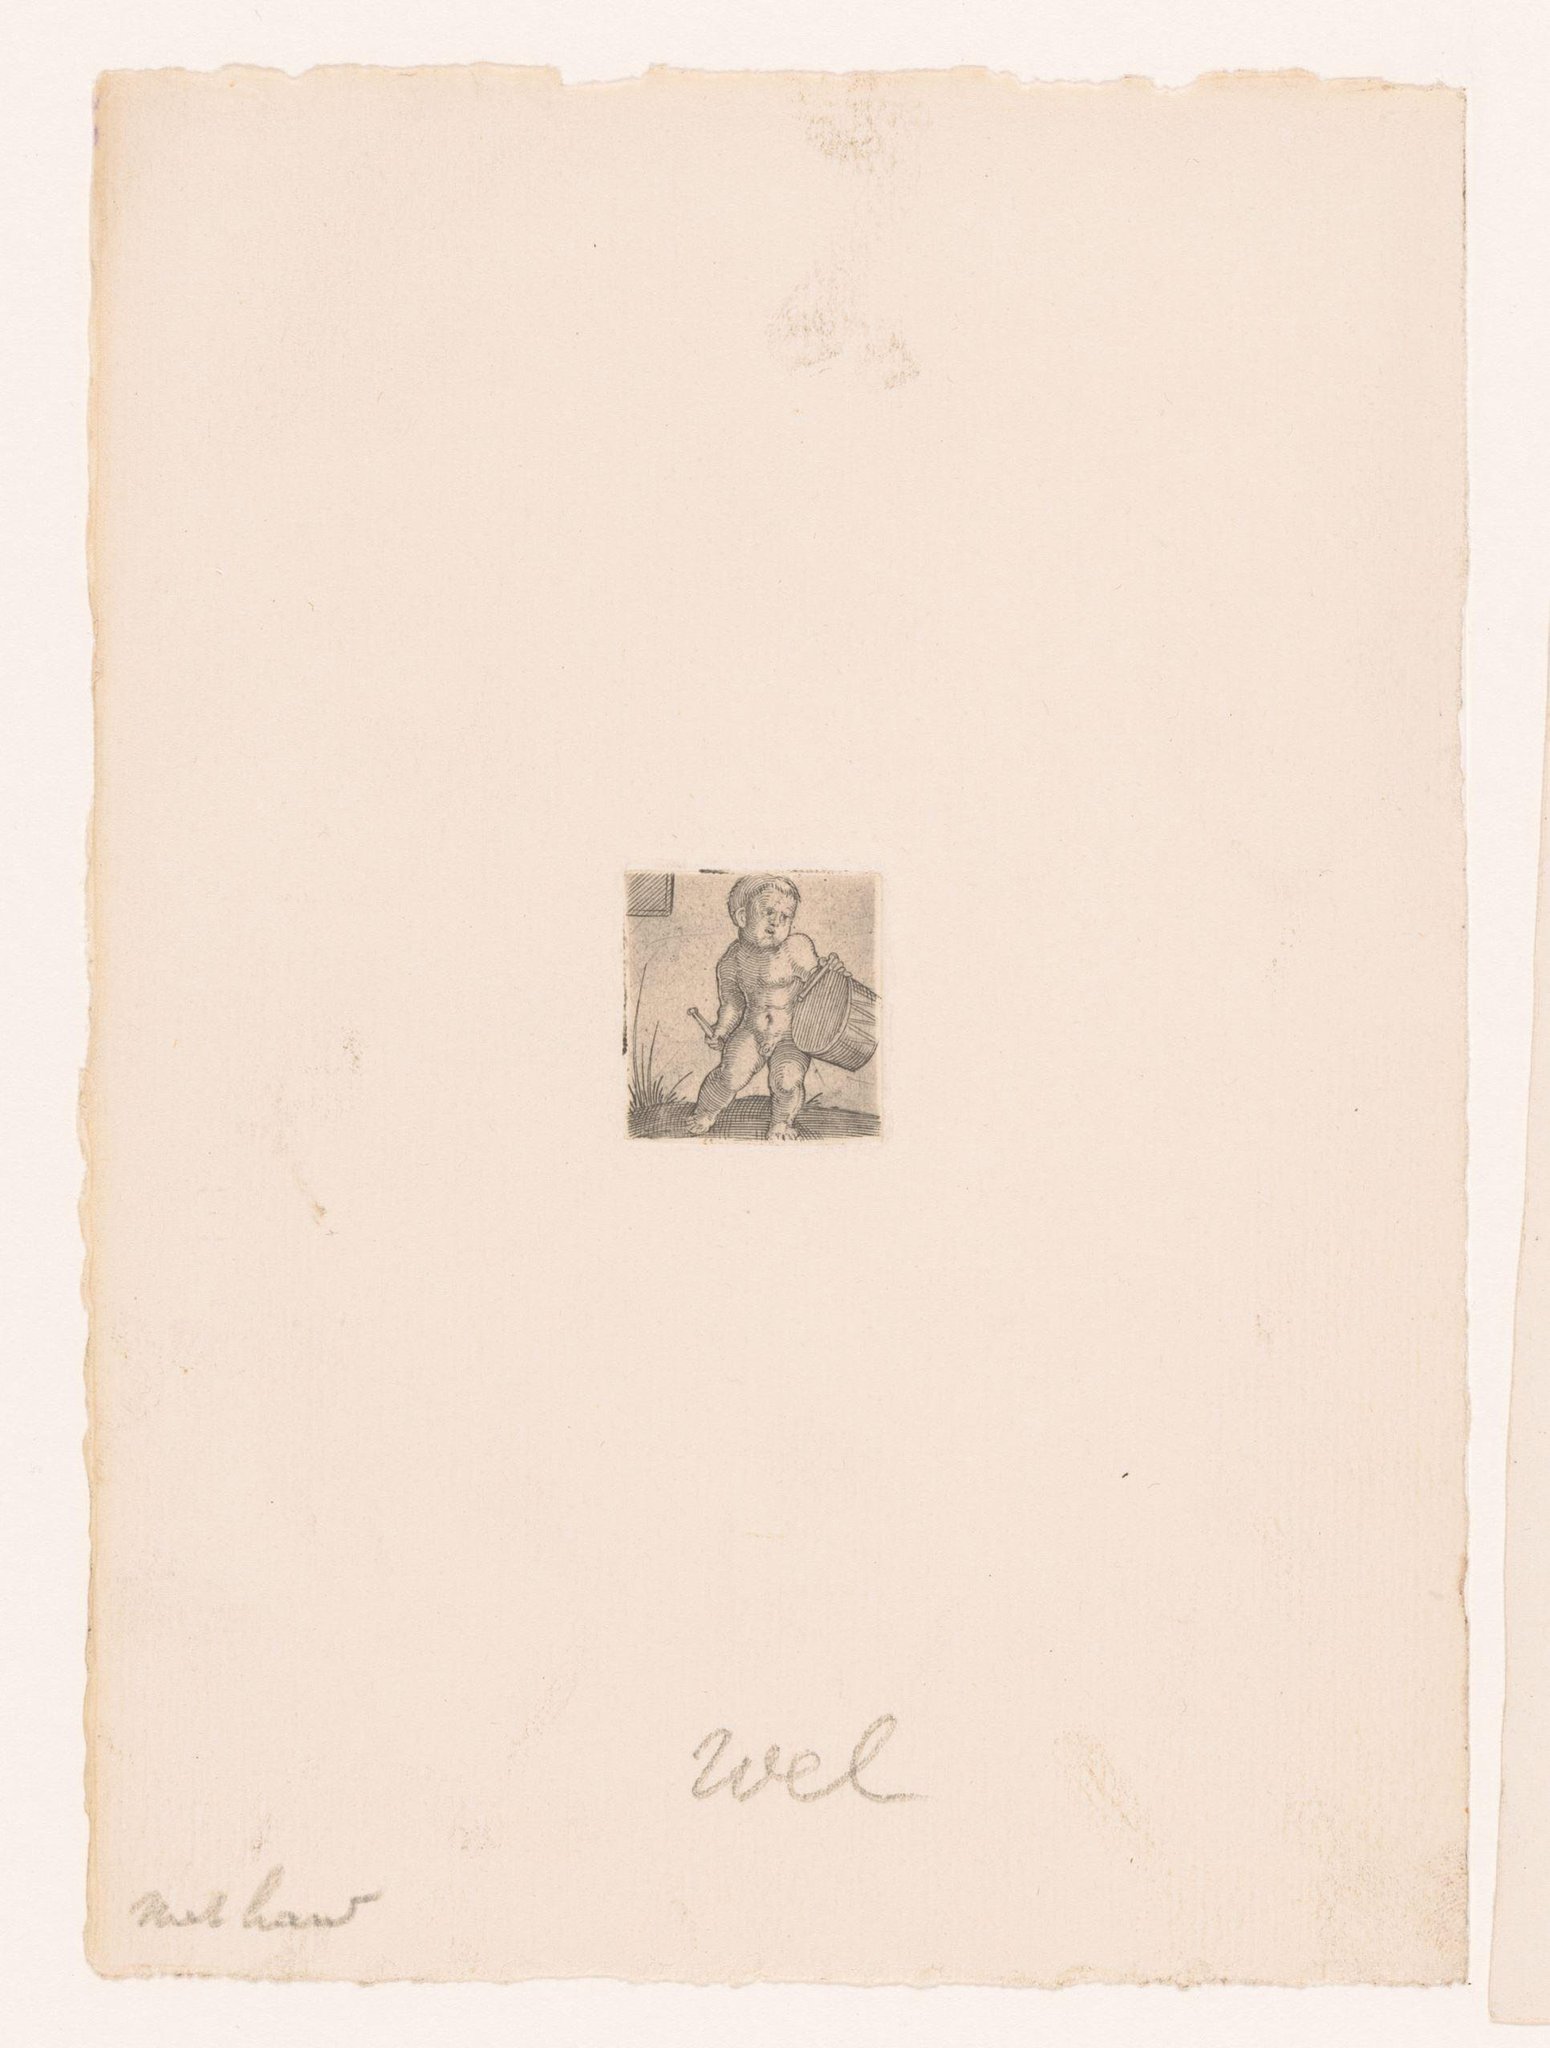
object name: print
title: Naakt kind met een trommel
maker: Anonymous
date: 1550-1599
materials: paper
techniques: engraving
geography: germany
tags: child, drum (musical instrument)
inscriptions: collector's mark: Lugt 2228